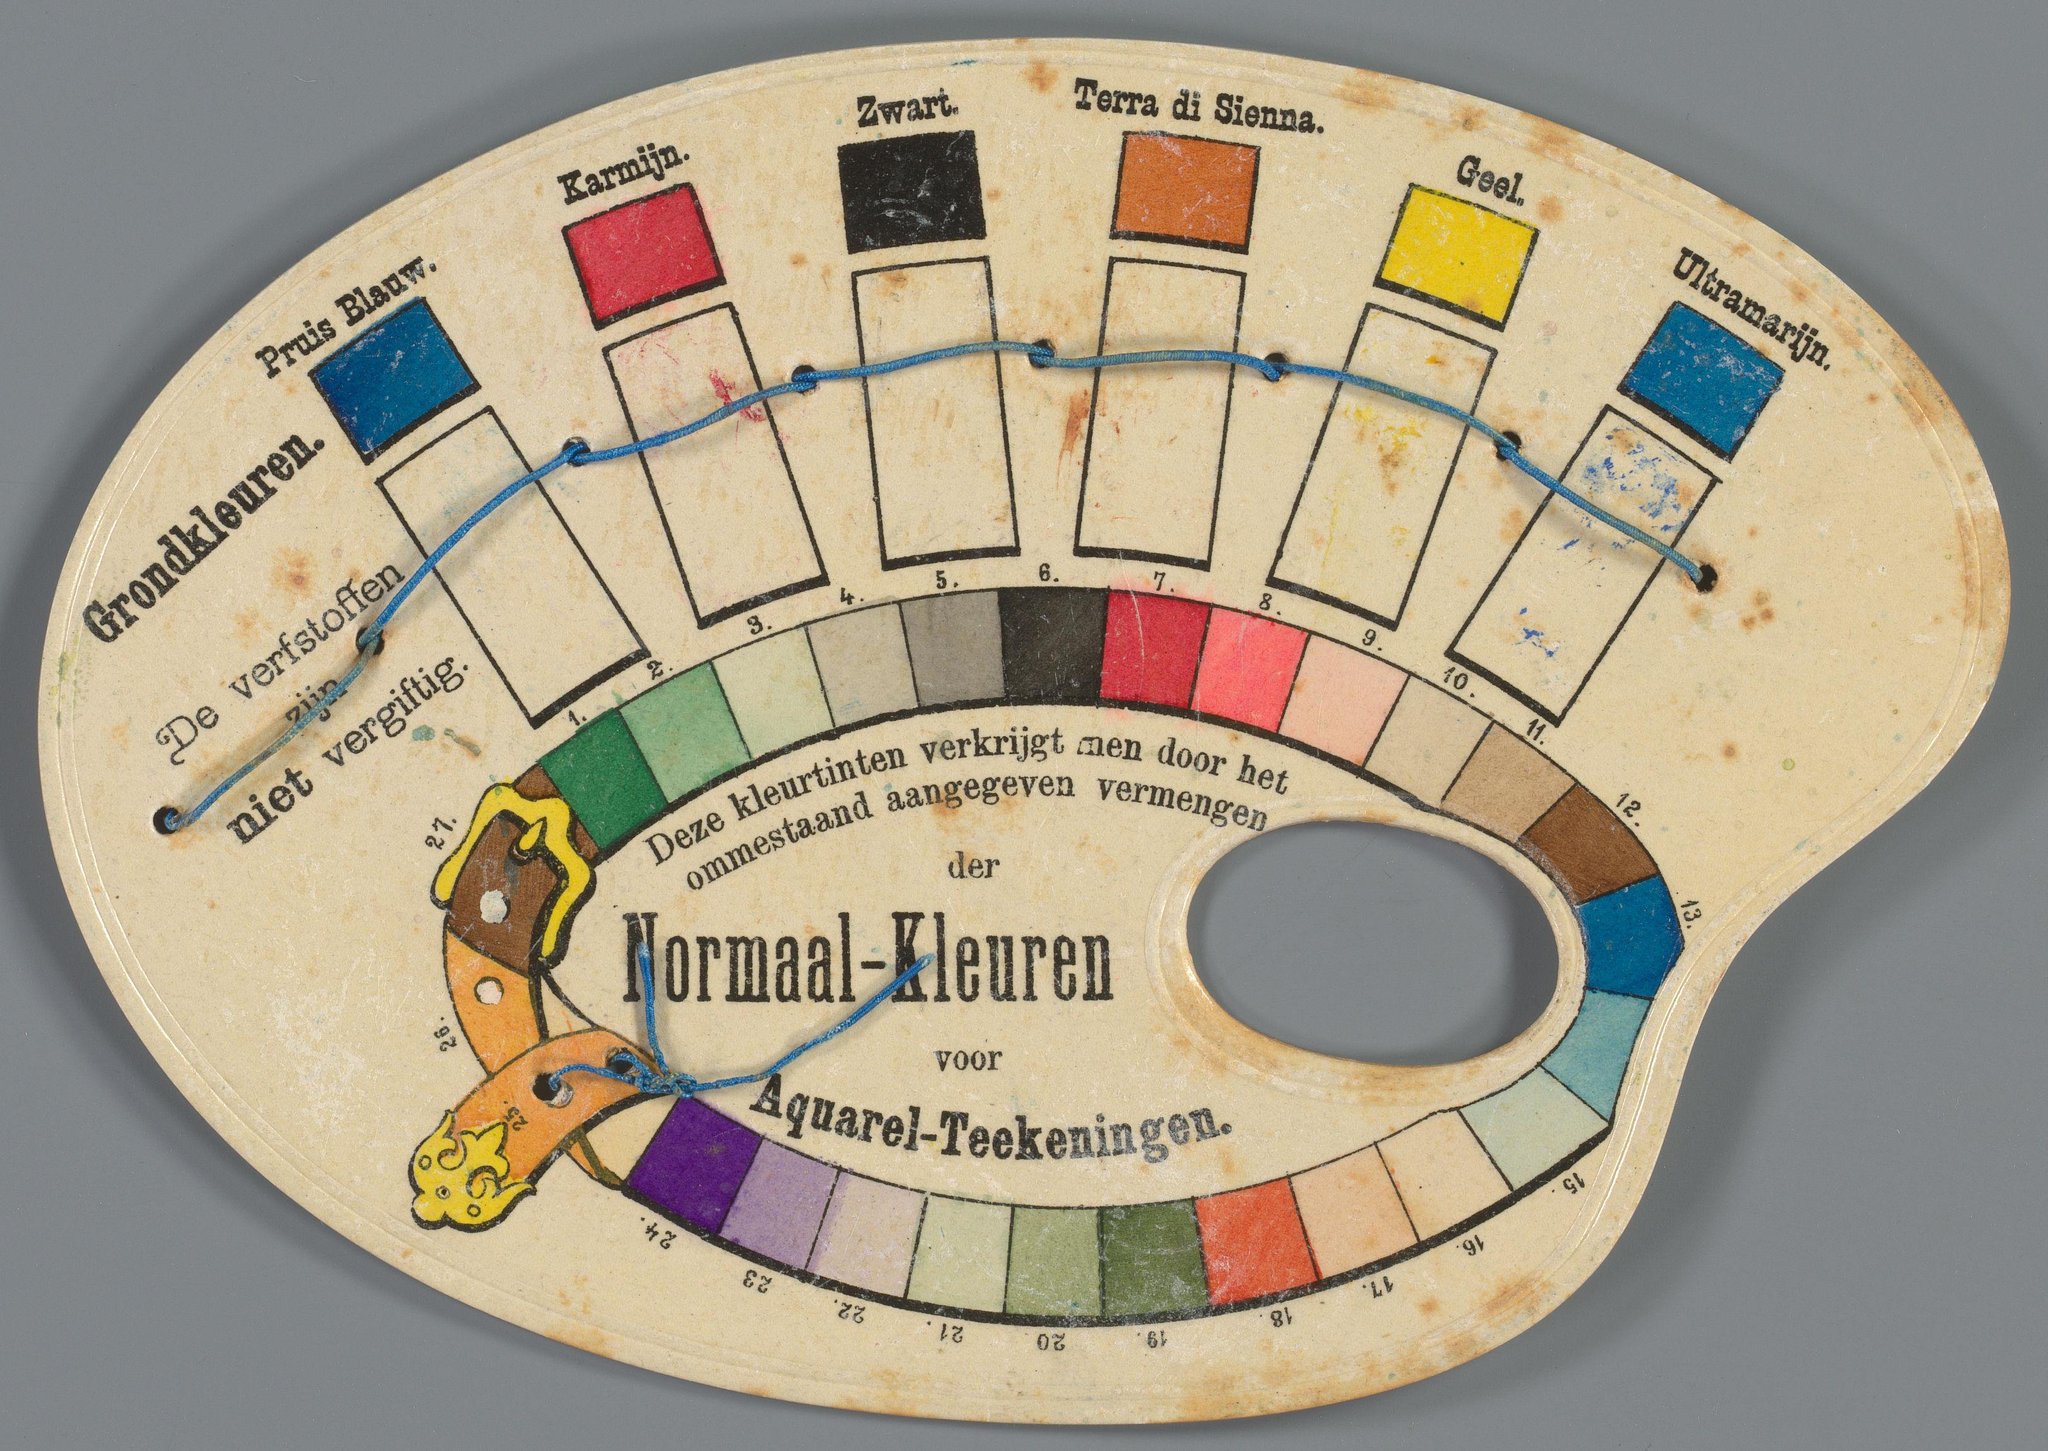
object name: print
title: Grondkleuren en menginstructies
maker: Anonymous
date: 1900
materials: cardboard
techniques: lithograph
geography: rotterdam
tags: palette, colours, pigments, and paints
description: Bijlage bij: Olfers, Marie van. Teeken- en kleur-abcboek door Marie von Olfers. Georgens' "Nieuwe kindertuin" 10 en 11. Rotterdam: Richters Boekhandel, [ca. 1900]. Hierbij een palet met waterverf. Beide zijn opgeborgen achter elastiek aan de binnenzijde van het voorplat van het genoemde boek. Aangezien de prentmaker onbekend is, is voor de rechtenbepaling van dit object gebruik gemaakt van de gegevens van de schrijfster.